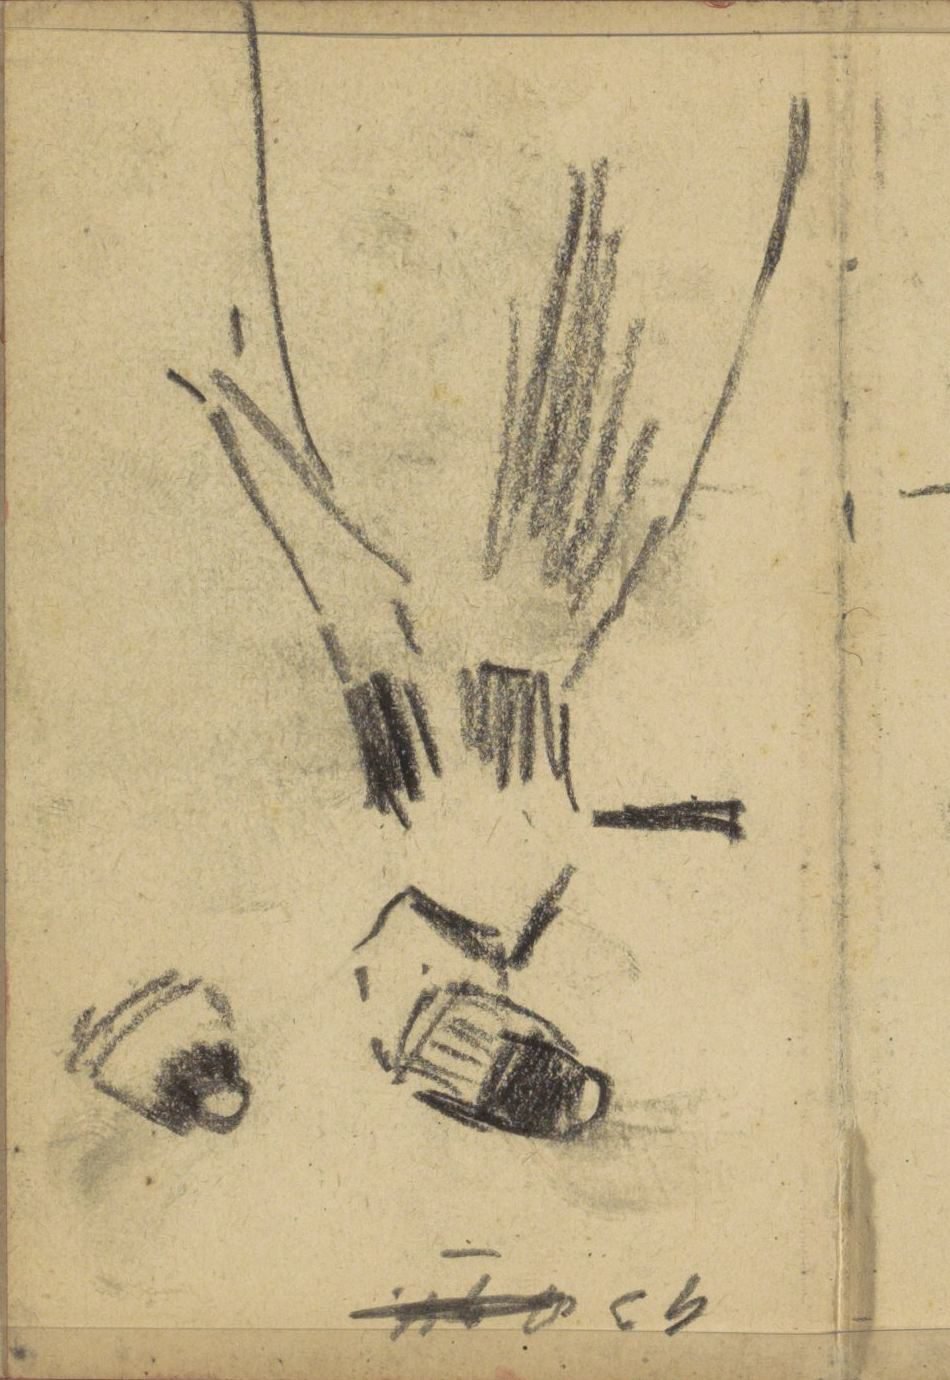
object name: sketchbook leaf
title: Staande vrouw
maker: george hendrik breitner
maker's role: draughtsman, painter, print maker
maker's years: 1857-1923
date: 1893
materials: chalk, paper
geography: amsterdam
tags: adult woman, standing figure - aa - female human figure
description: Pagina 161 uit een als schetsboek gebruikte agenda met 80 bladen.